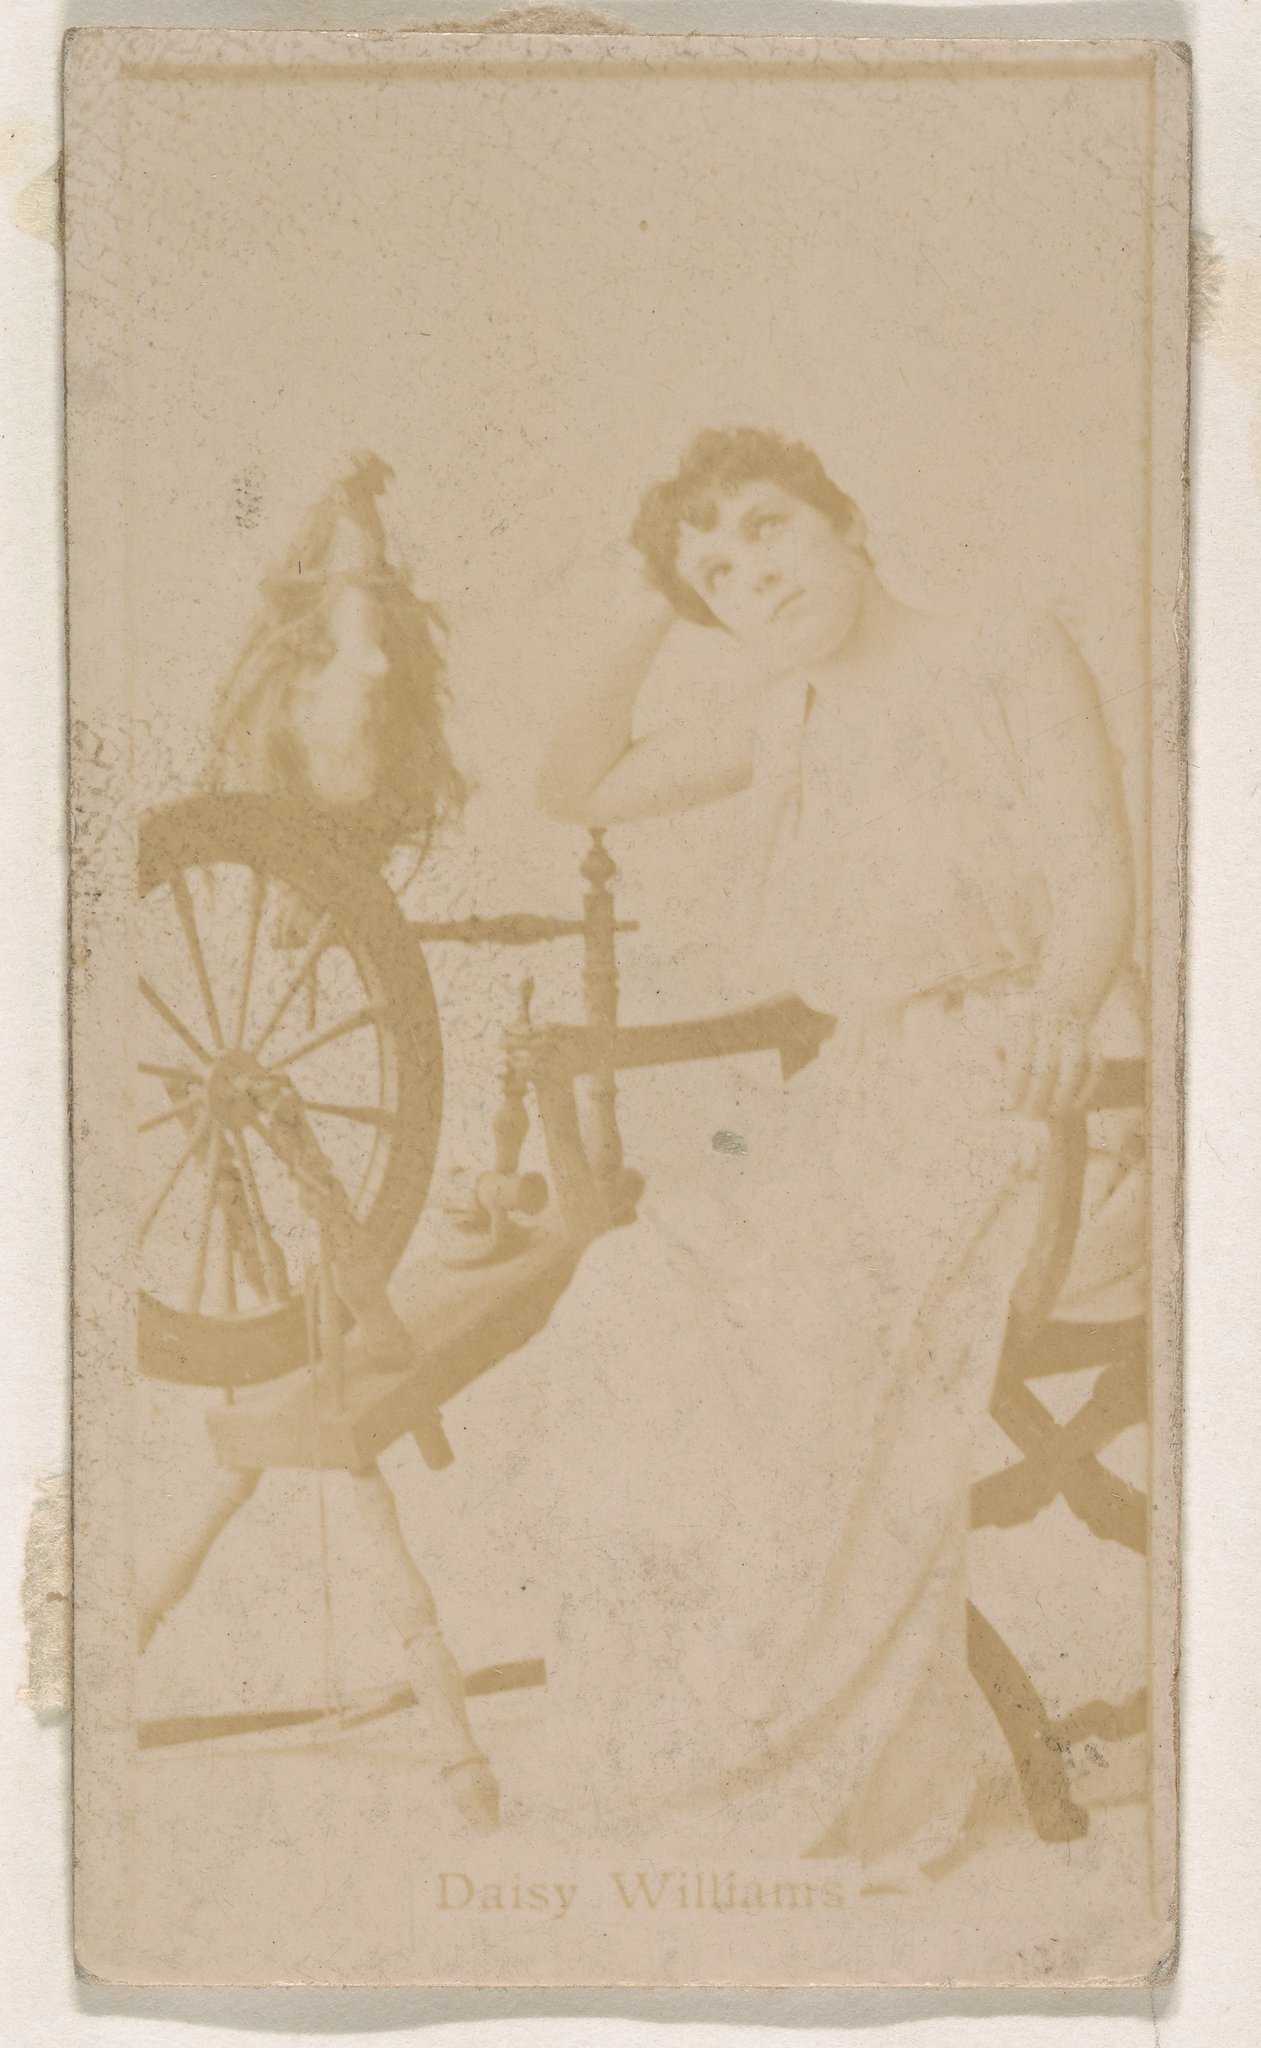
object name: photograph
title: Daisy Williams, from the Actresses series (N245) issued by Kinney Brothers to promote Sweet Caporal Cigarettes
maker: kinney brothers tobacco company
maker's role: publisher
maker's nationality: american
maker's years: 1869-2011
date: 1890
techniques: albumen silver print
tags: portraits,women,actresses